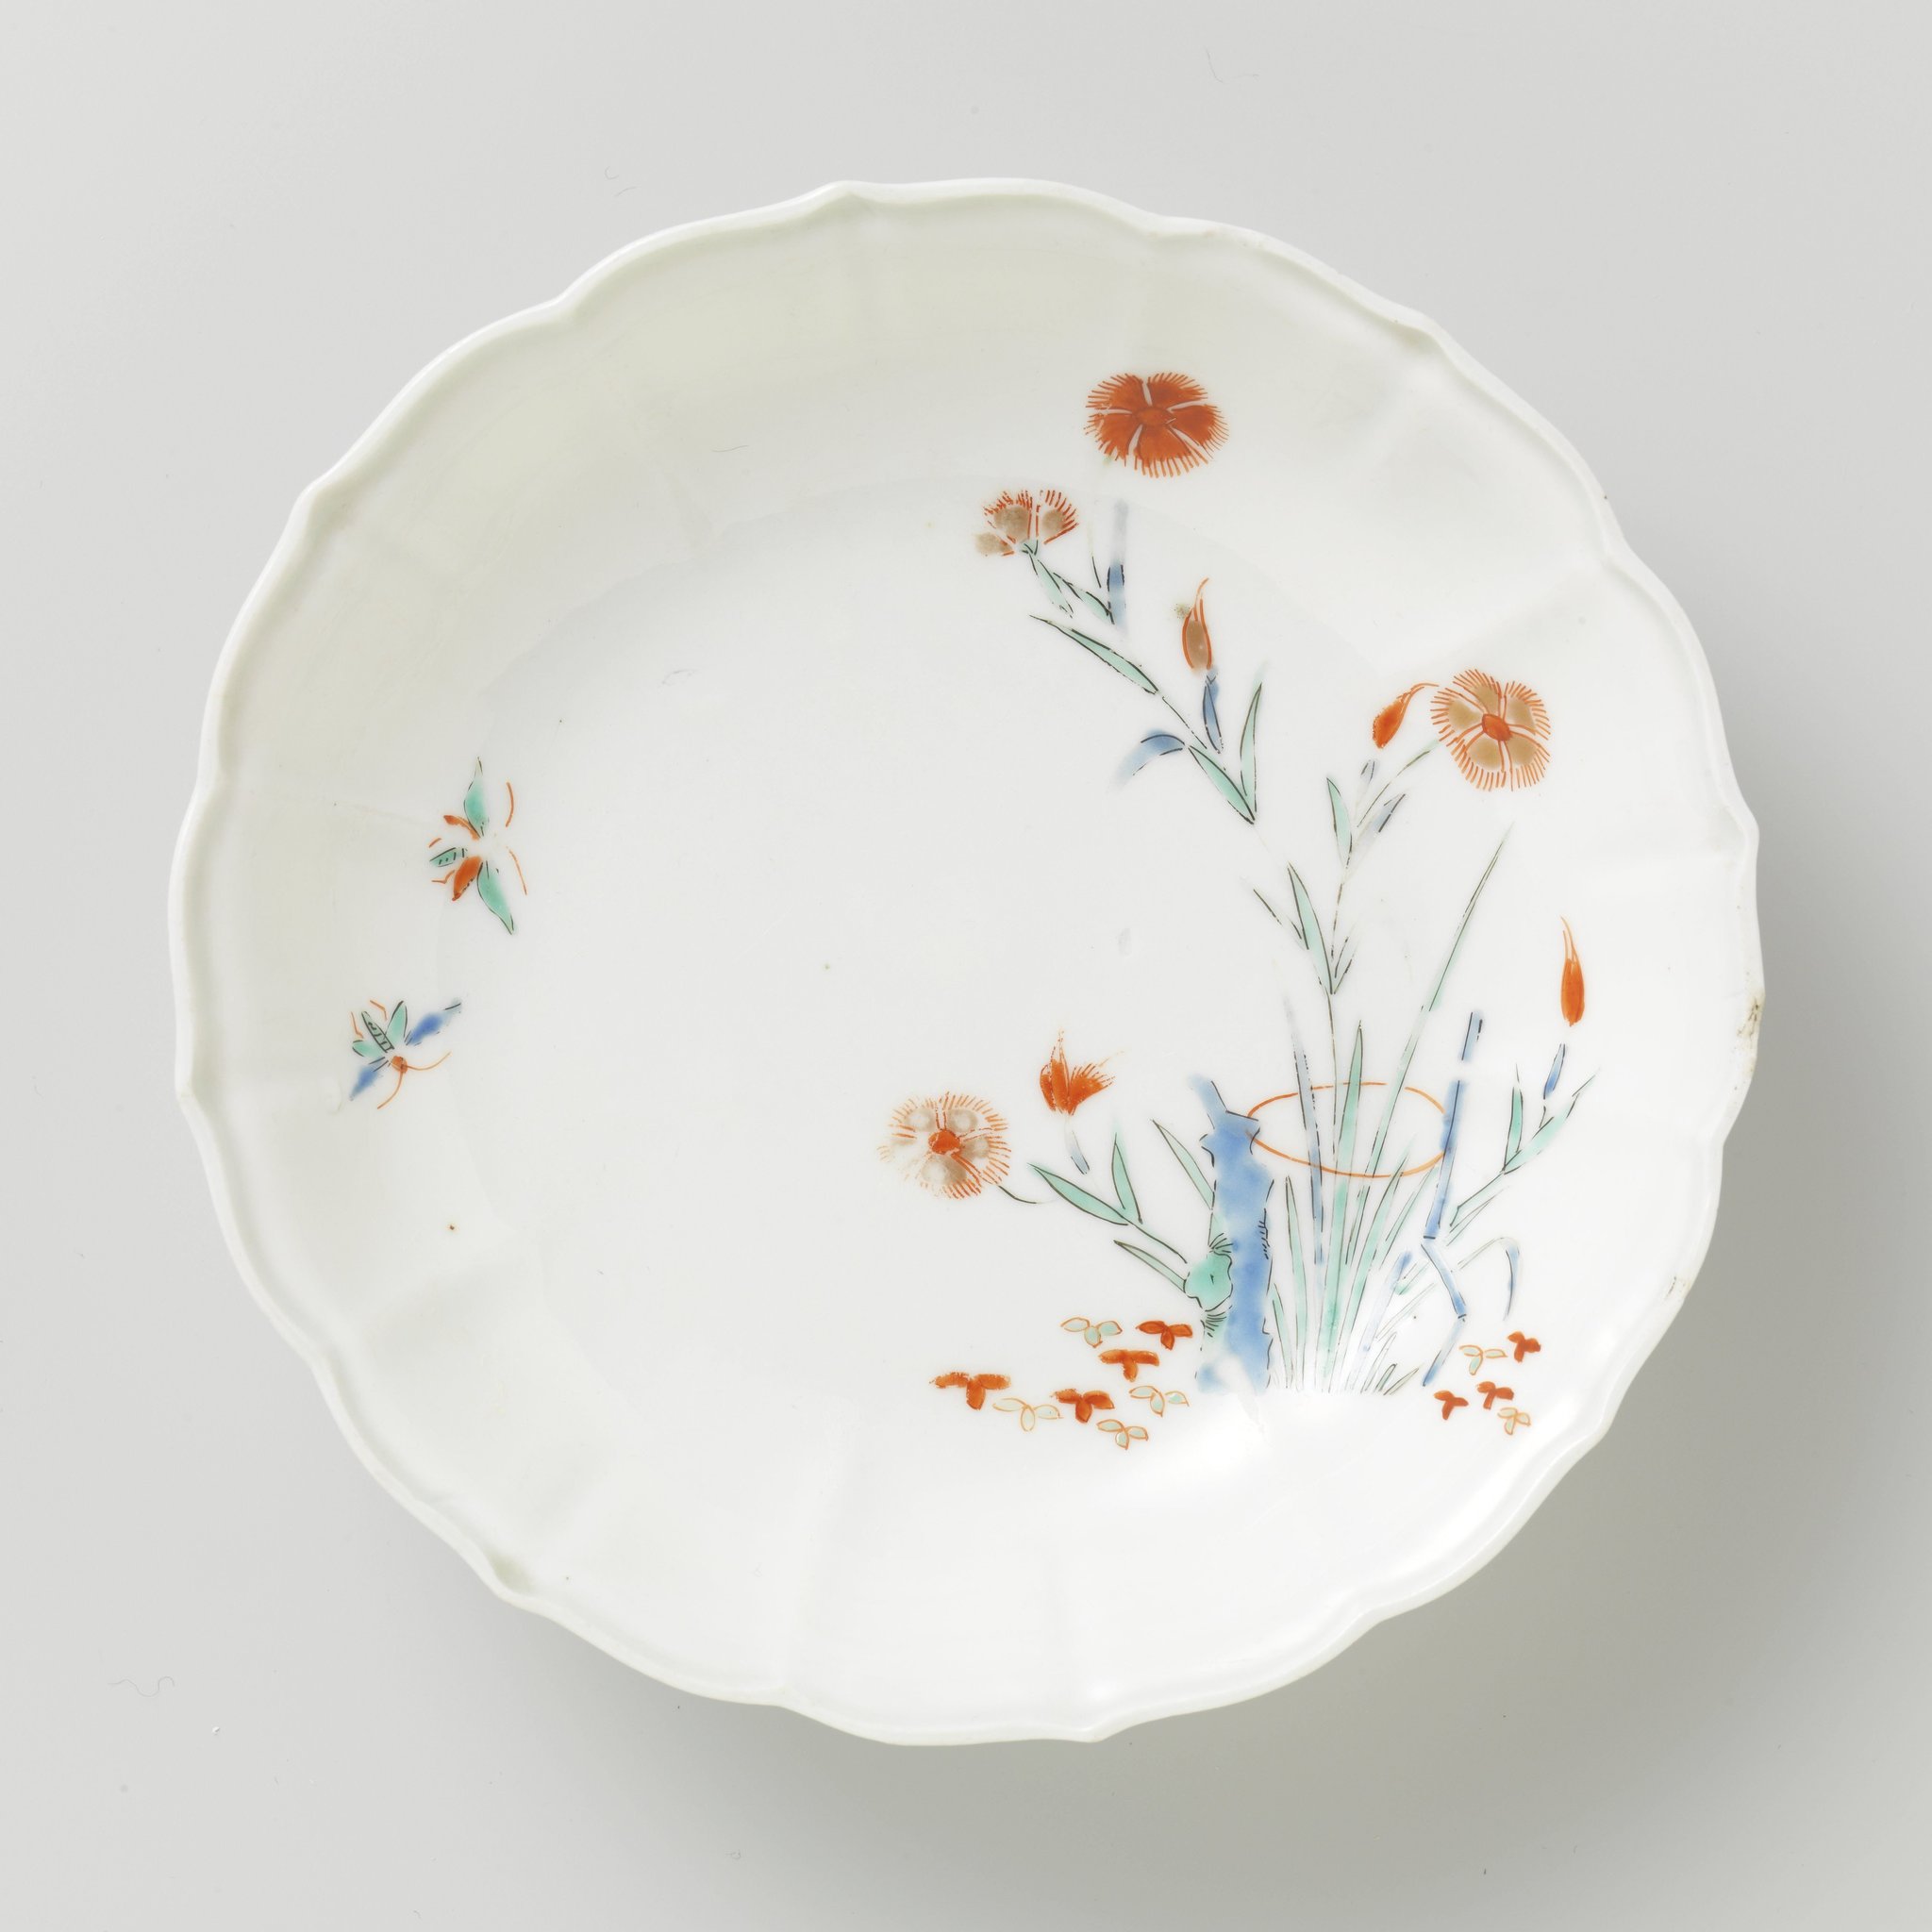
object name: dish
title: Saucer-dish with flowering plants and butterflies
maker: Anonymous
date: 1700-1799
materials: glaze, gold, paint, porcelain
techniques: forming, gilding, turning, vitrification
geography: arita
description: Schaal van porselein met een geribde wand en geschulpte rand, beschilderd op het glazuur in blauw, rood, groen, zwart en goud. Op de voorzijde bloeiende planten (prachtanjer) en twee vlinders. Een proen op de onderzijde. Arita, Kakiemon.